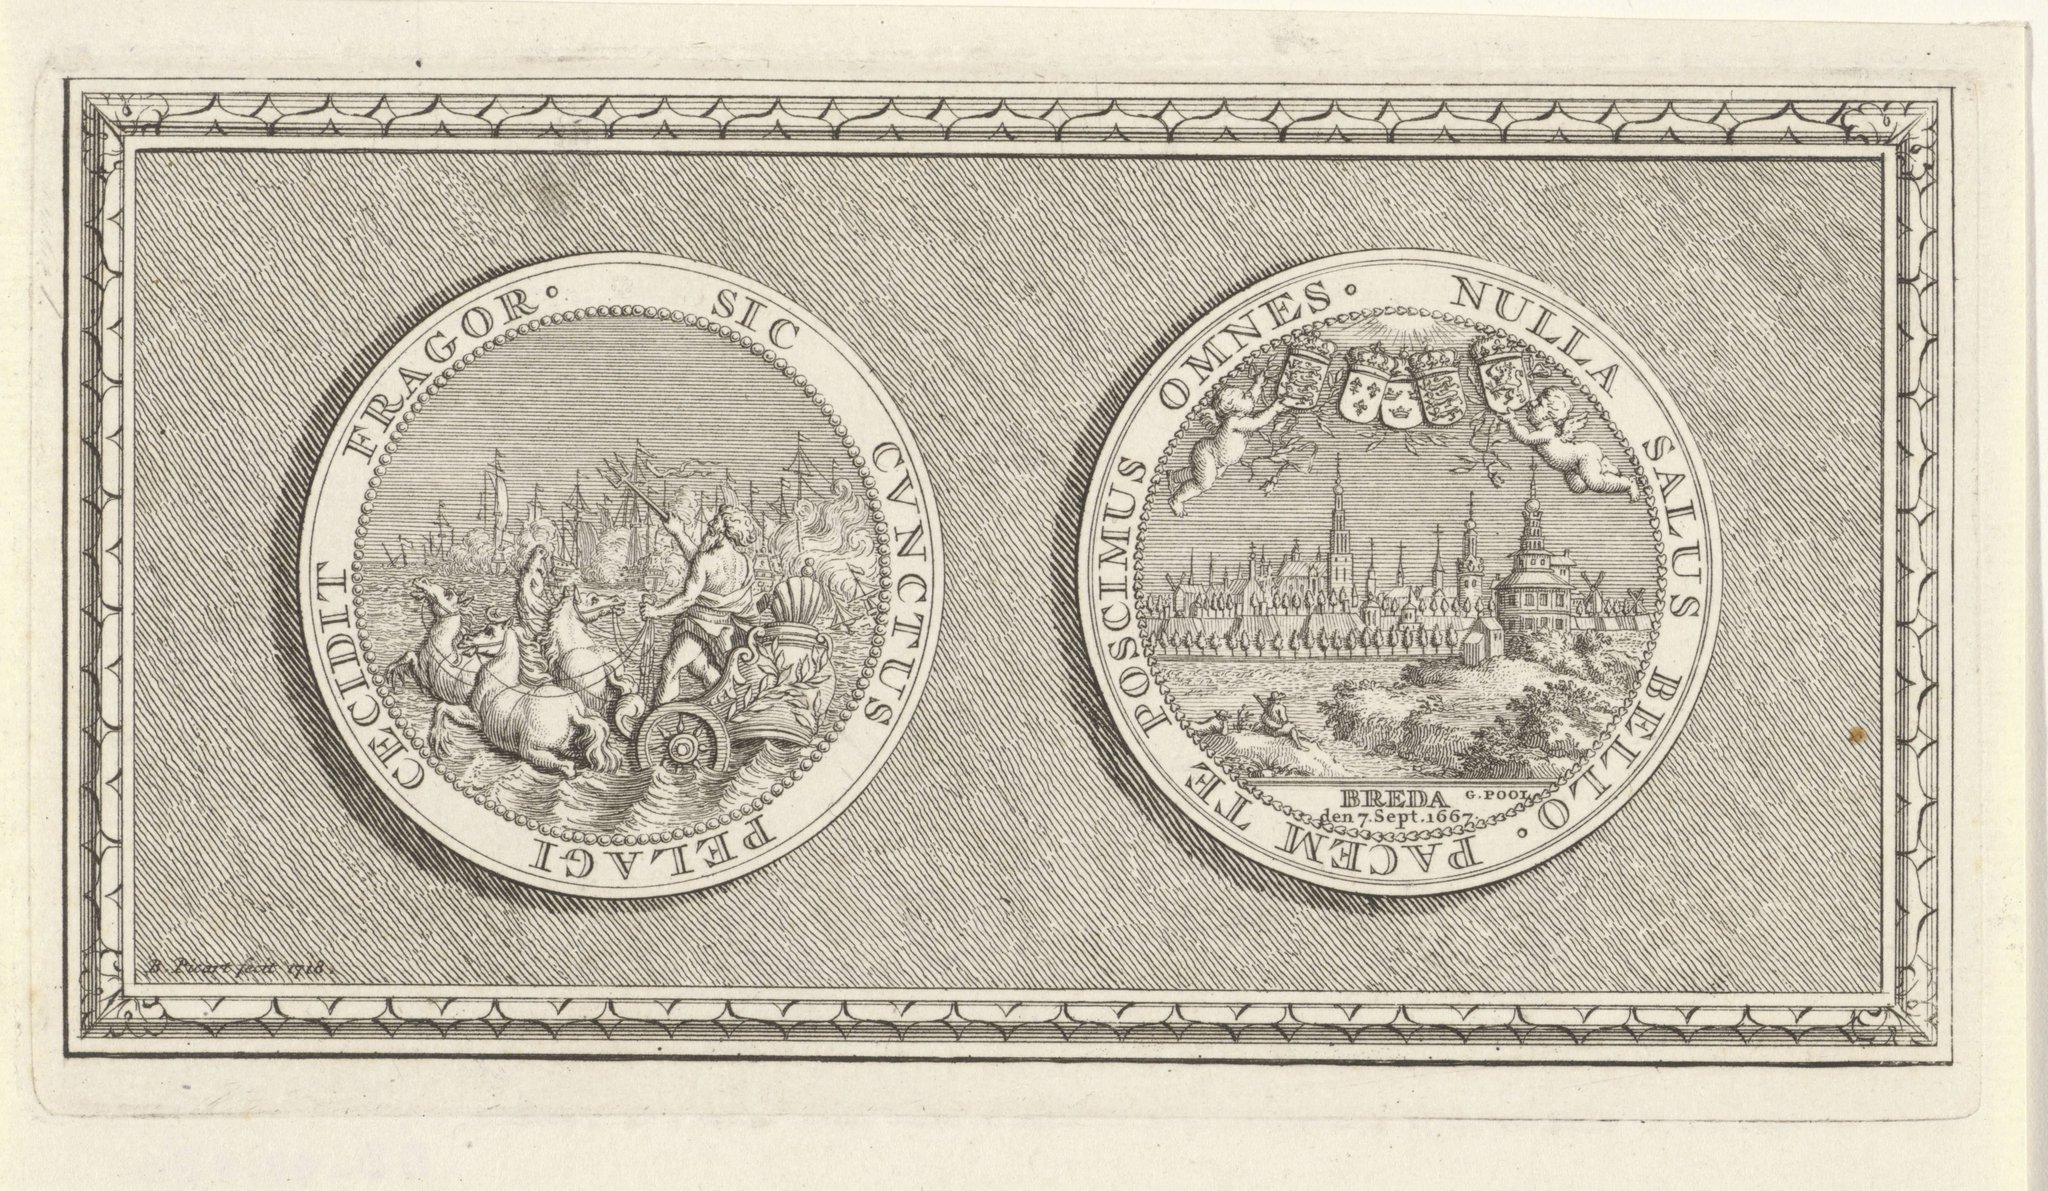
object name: print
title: Penning ter ere van de Vrede van Breda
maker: bernard picart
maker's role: draughtsman, print maker, publisher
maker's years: 1673-1733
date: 1718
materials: paper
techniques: engraving, etching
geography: amsterdam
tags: medal (considered as a piece of sculpture, regardless of its specific function), raid on the medway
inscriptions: collector's mark: Lugt 2228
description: Penning ter ere van de Vrede van Breda, die werd gesloten op 31 juli 1667 tussen de Republiek der Zeven Verenigde Nederlanden, Engeland, Frankrijk en Denemarken. Hiermee kwam een einde aan de Tweede Engelse Oorlog. Op de voorzijde Neptunus en op de achtergrond de Tocht naar Chatham. Op de achterzijde de stad Breda.